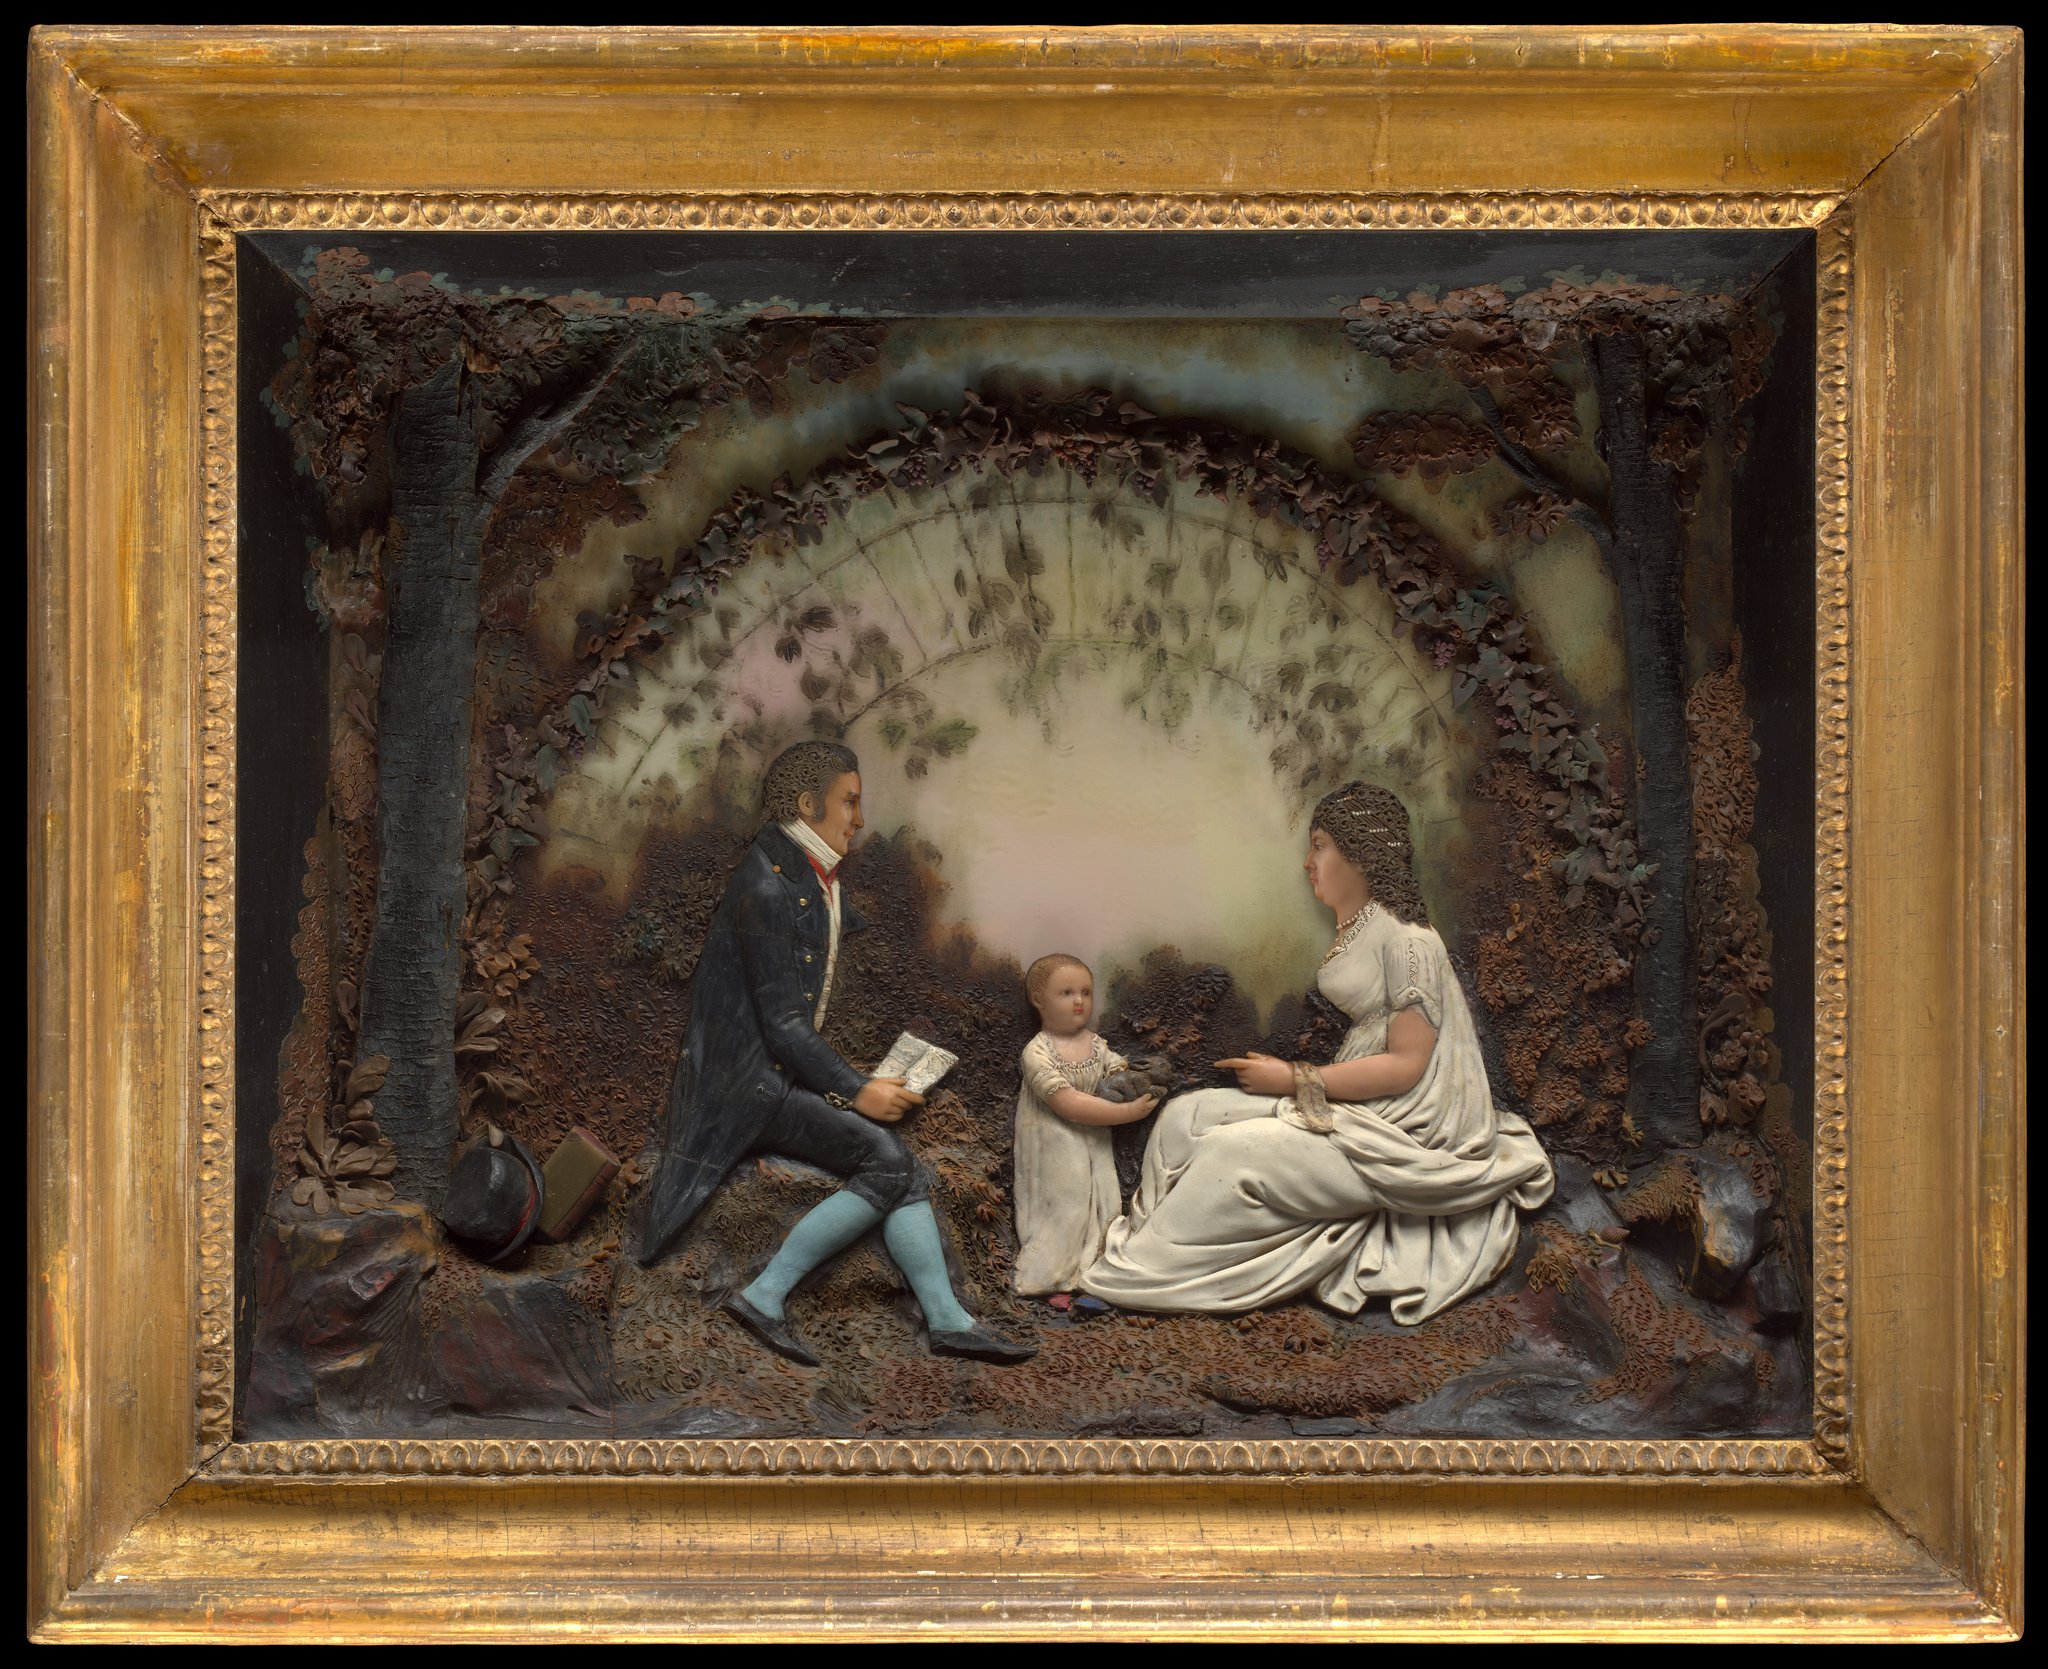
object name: minature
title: Father, Mother, and Child in a Park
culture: american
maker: john christian rauschner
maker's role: artist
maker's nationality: german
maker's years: 1760-1812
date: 1810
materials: glass, paint, wax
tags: children,men,fathers,mothers,women,family